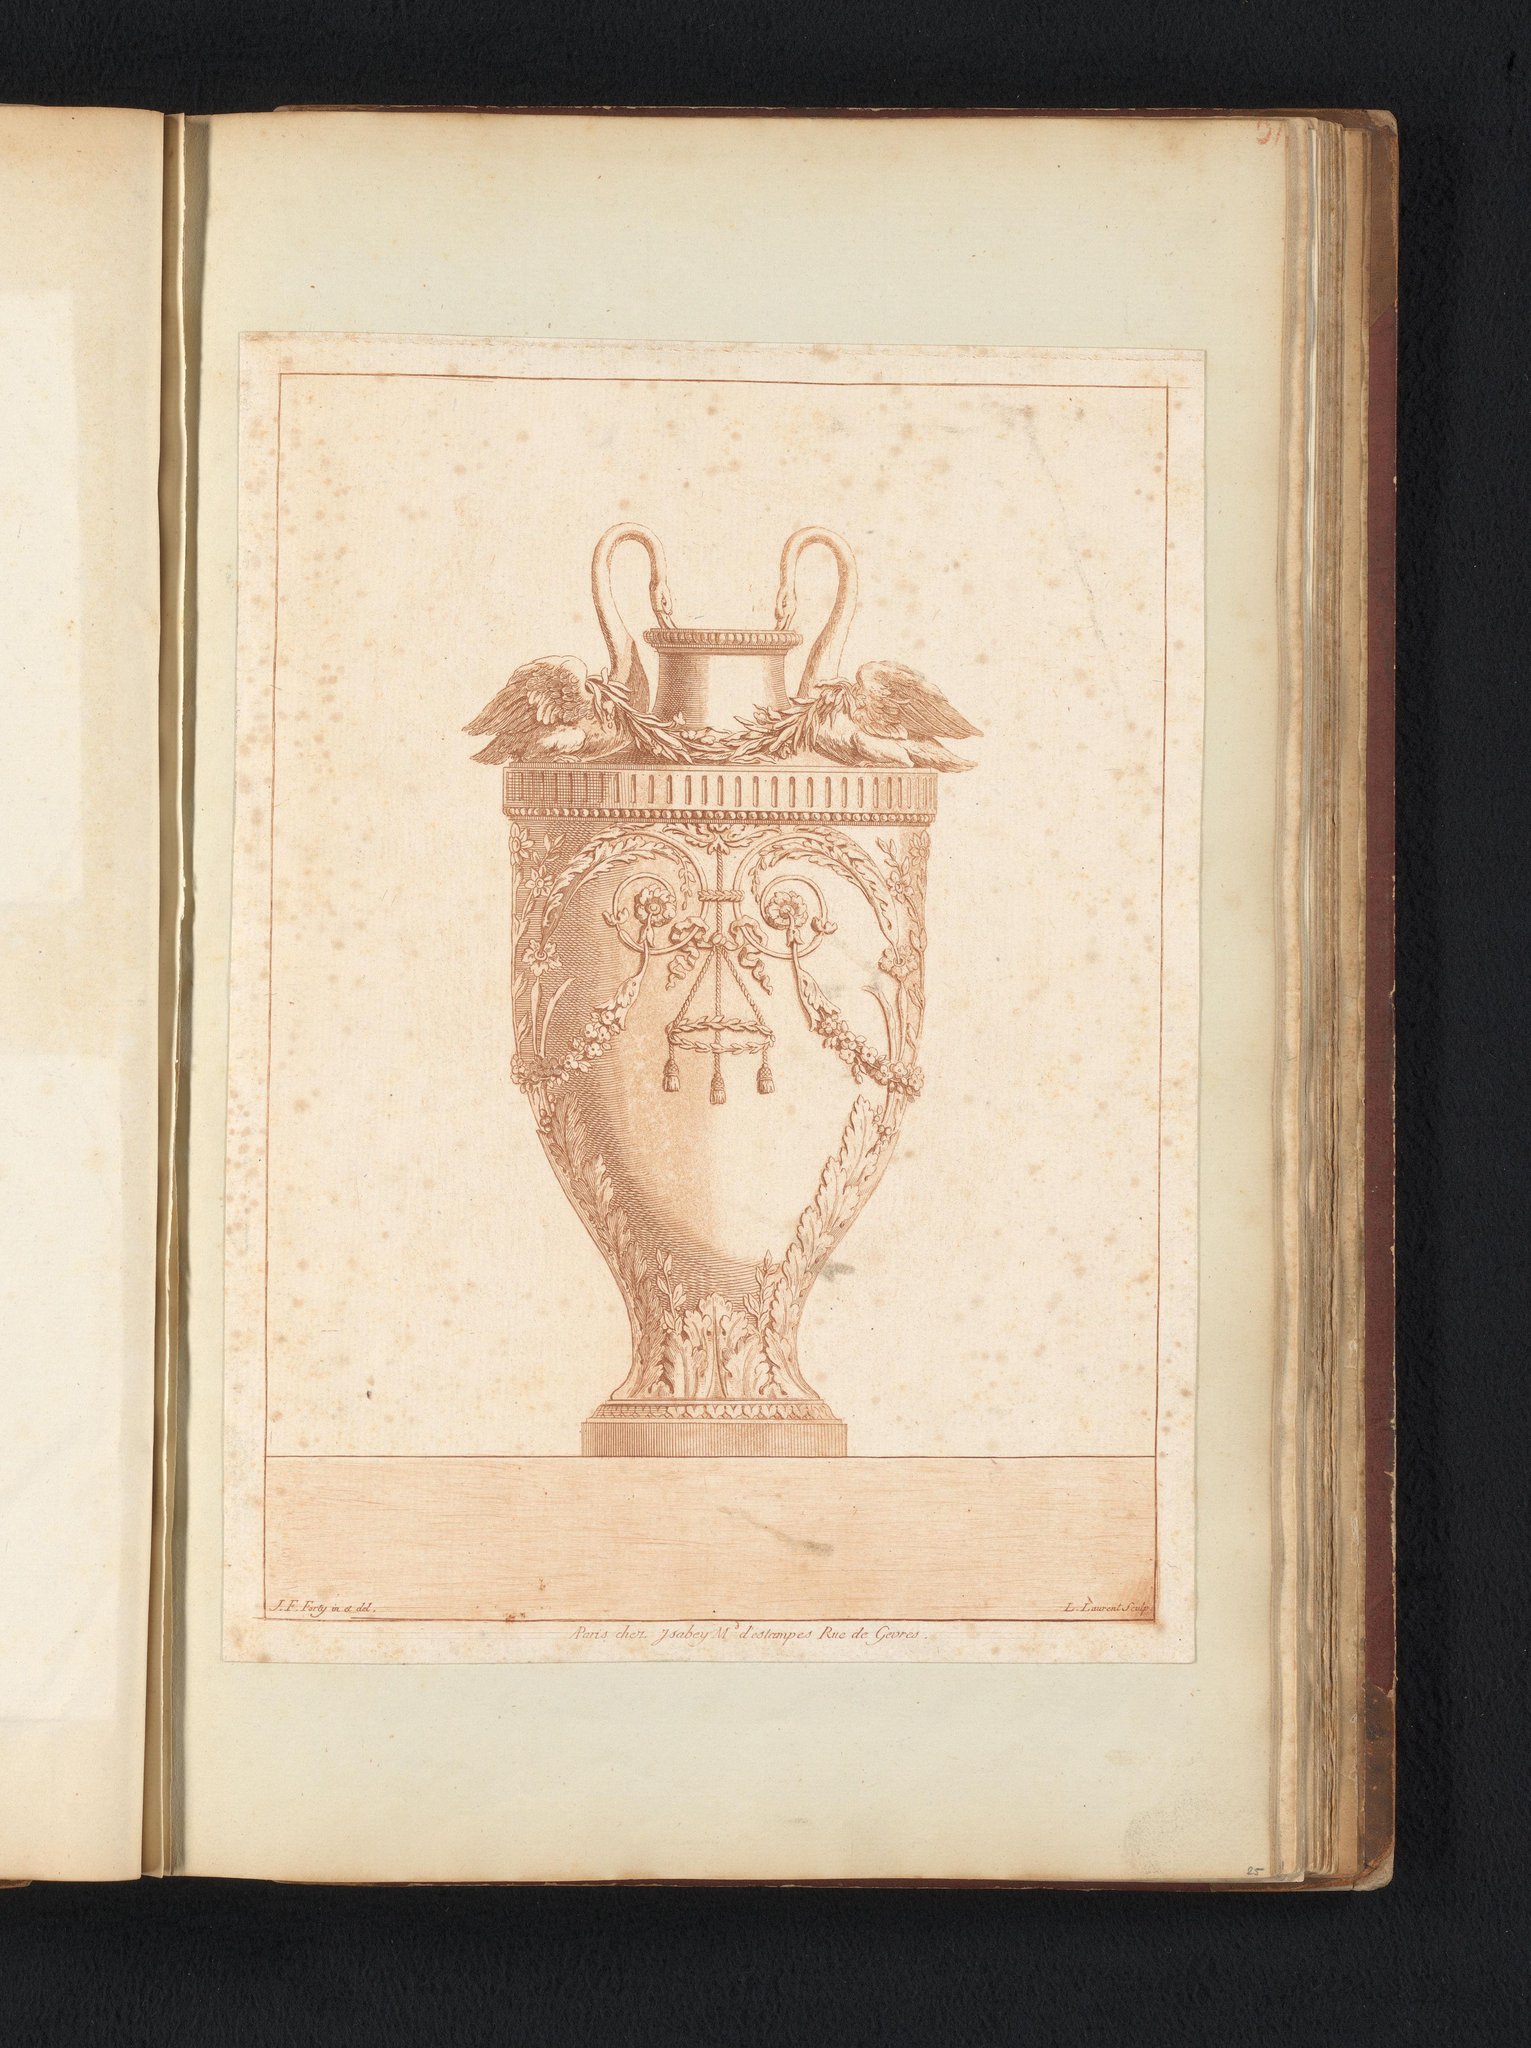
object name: print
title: Vaas met zwanen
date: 1775-1785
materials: paper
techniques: aquatint, engraving, etching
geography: paris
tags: containers, garden vase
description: Een geornamenteerde vaas met ranken, bloemmotieven en handvaten in de vorm van zwanen. Onderdeel van het tweede van twee albums met ingeplakte prenten en tekeningen te dienen als tekenvoorbeelden.